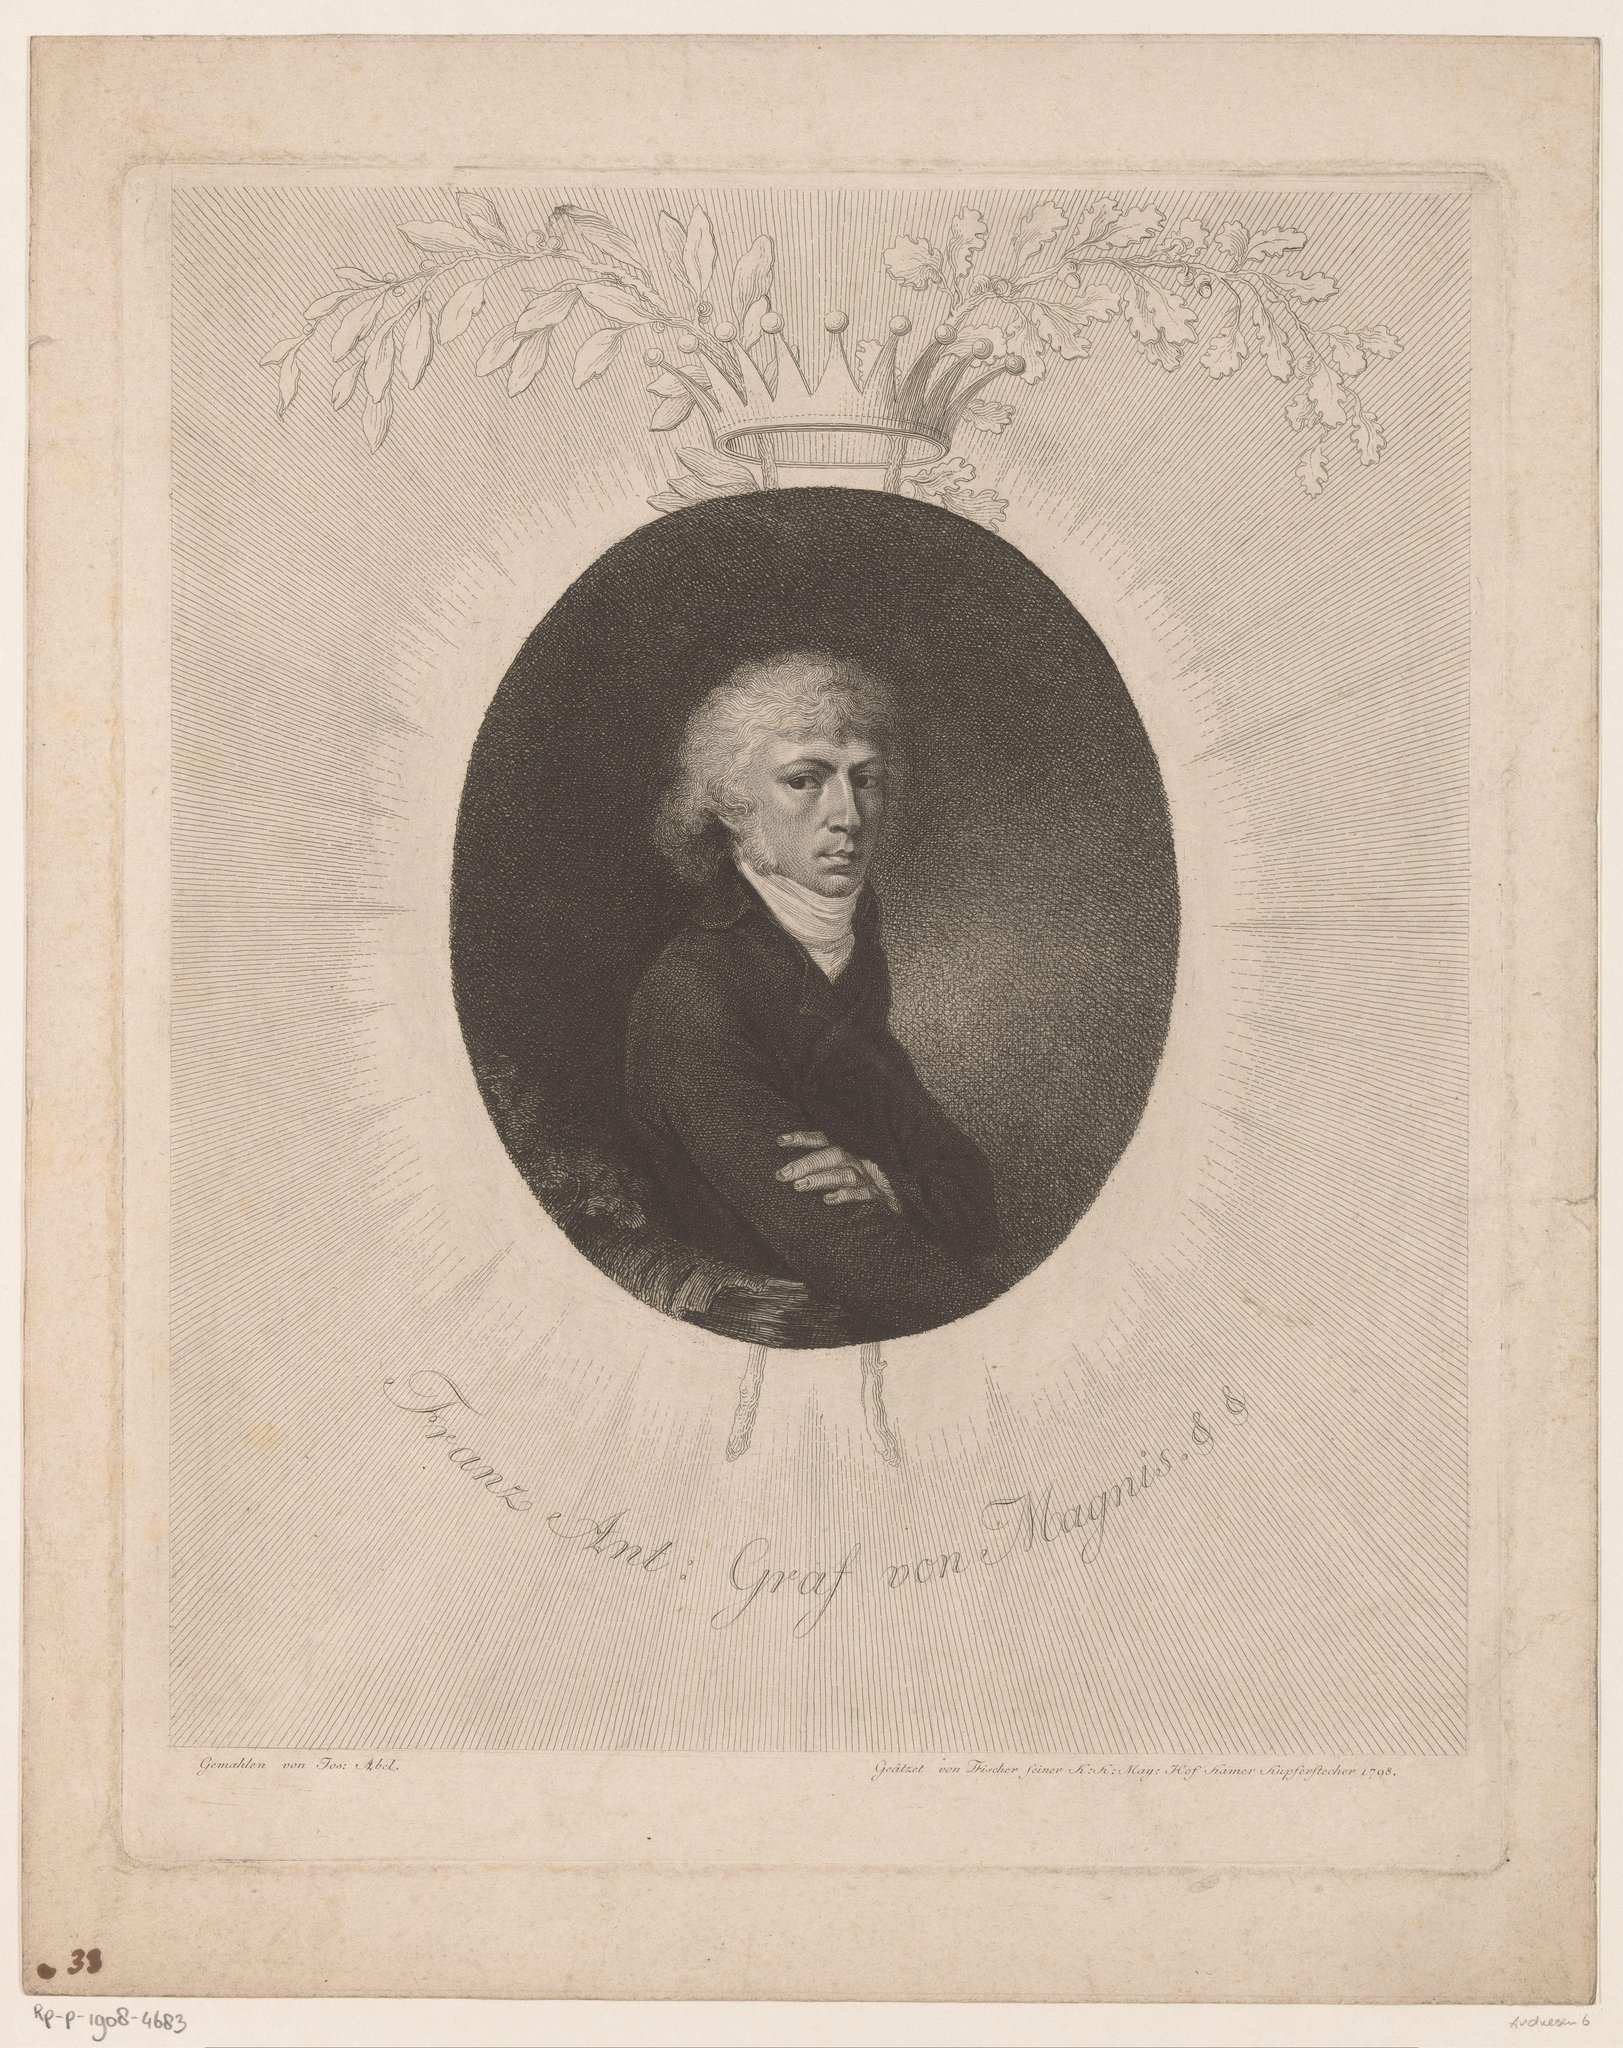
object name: print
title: Portret van Franz Graf von Magnis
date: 1798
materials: paper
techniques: etching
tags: crown (symbol of sovereignty), historical persons, trees: olive-tree (+ branch, stick)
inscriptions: collector's mark: Lugt 2228